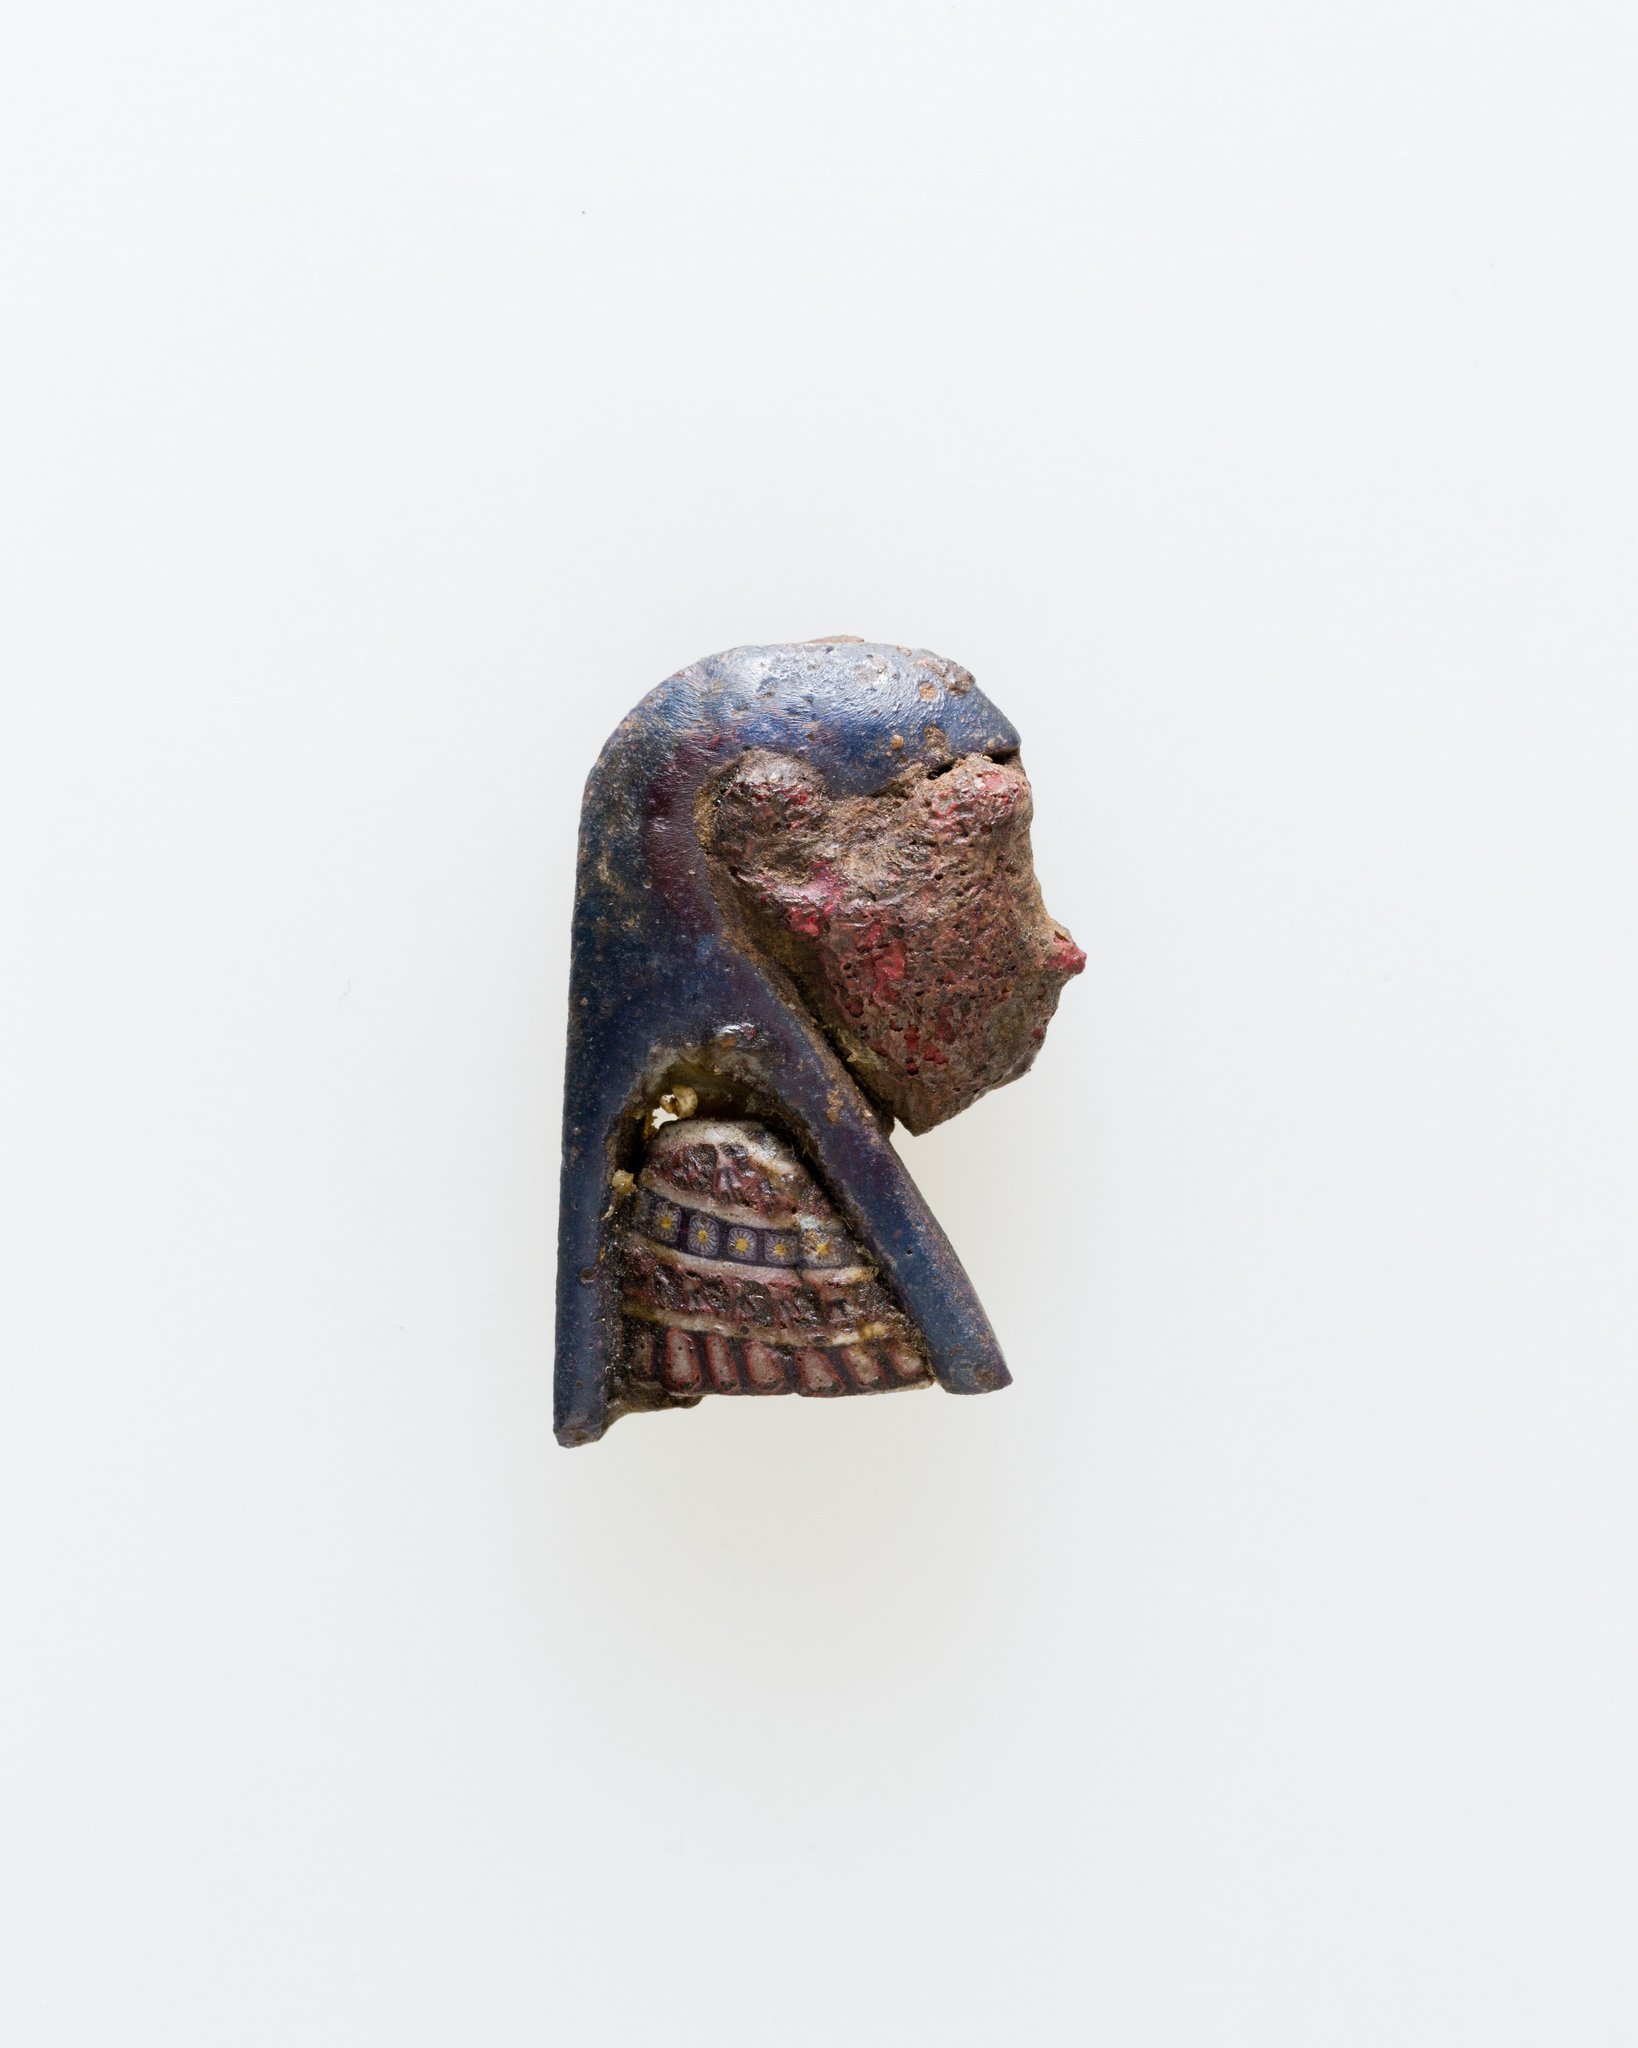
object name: inlay, bust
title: Inlay, profile bust fitted from sections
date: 200 BCE-100 CE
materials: glass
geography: egypt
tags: human figures